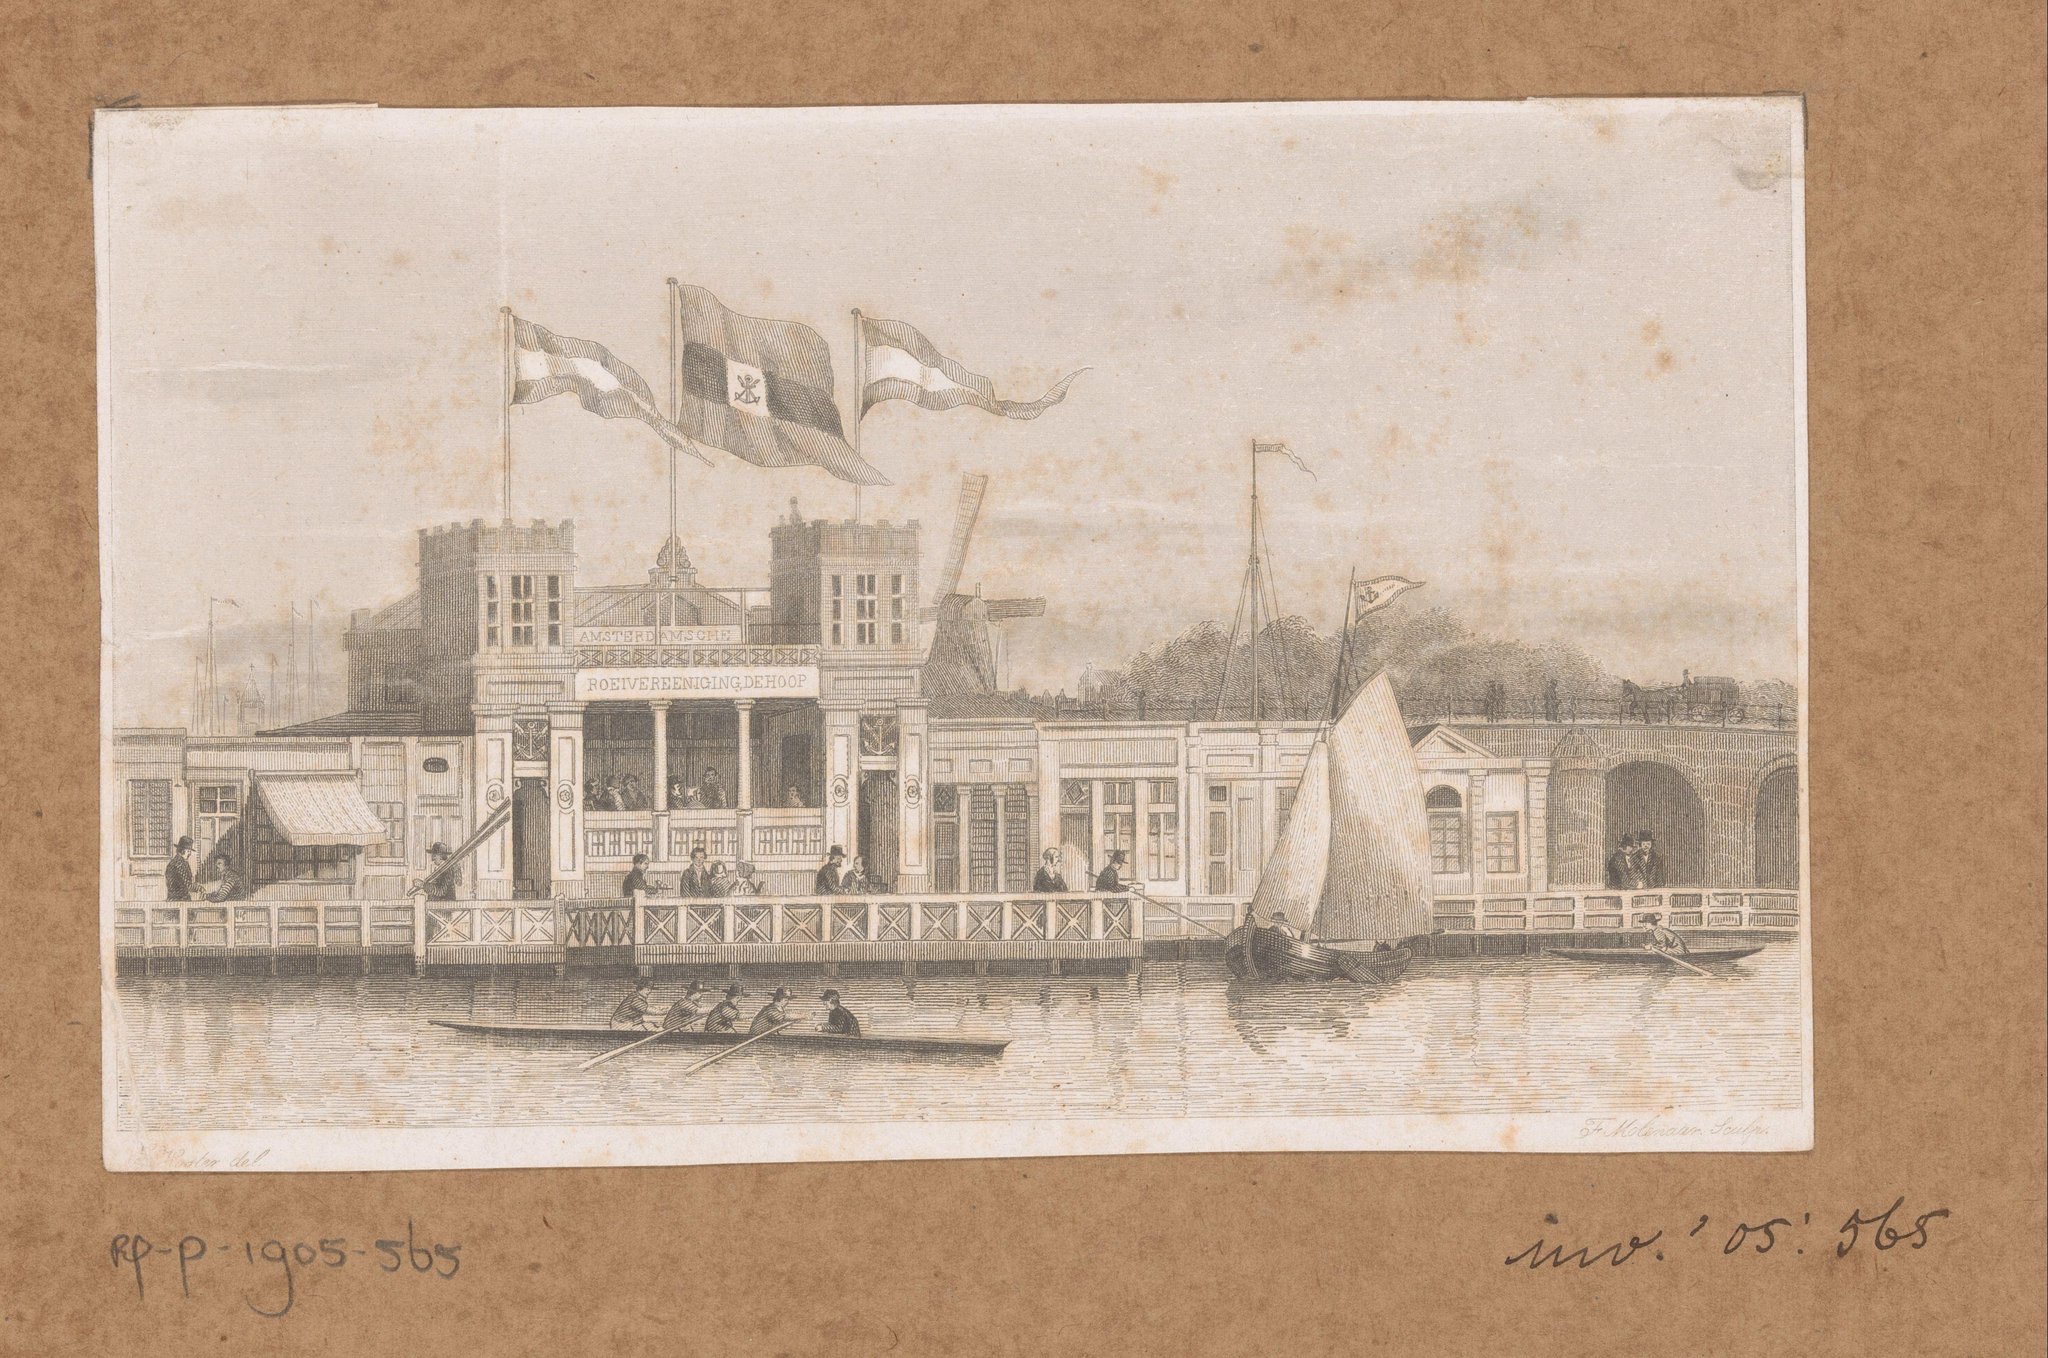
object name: print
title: Gebouw van de Amsterdamse roeivereniging De Hoop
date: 1848-1900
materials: paper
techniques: engraving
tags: rowing, canoeing, etc. (sport) (+ organization, club (sports, games, etc.)), sailing-ship, sailing-boat, rowing facing backward, pulling, boat-house, shed, amsterdam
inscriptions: collector's mark: Lugt 2228